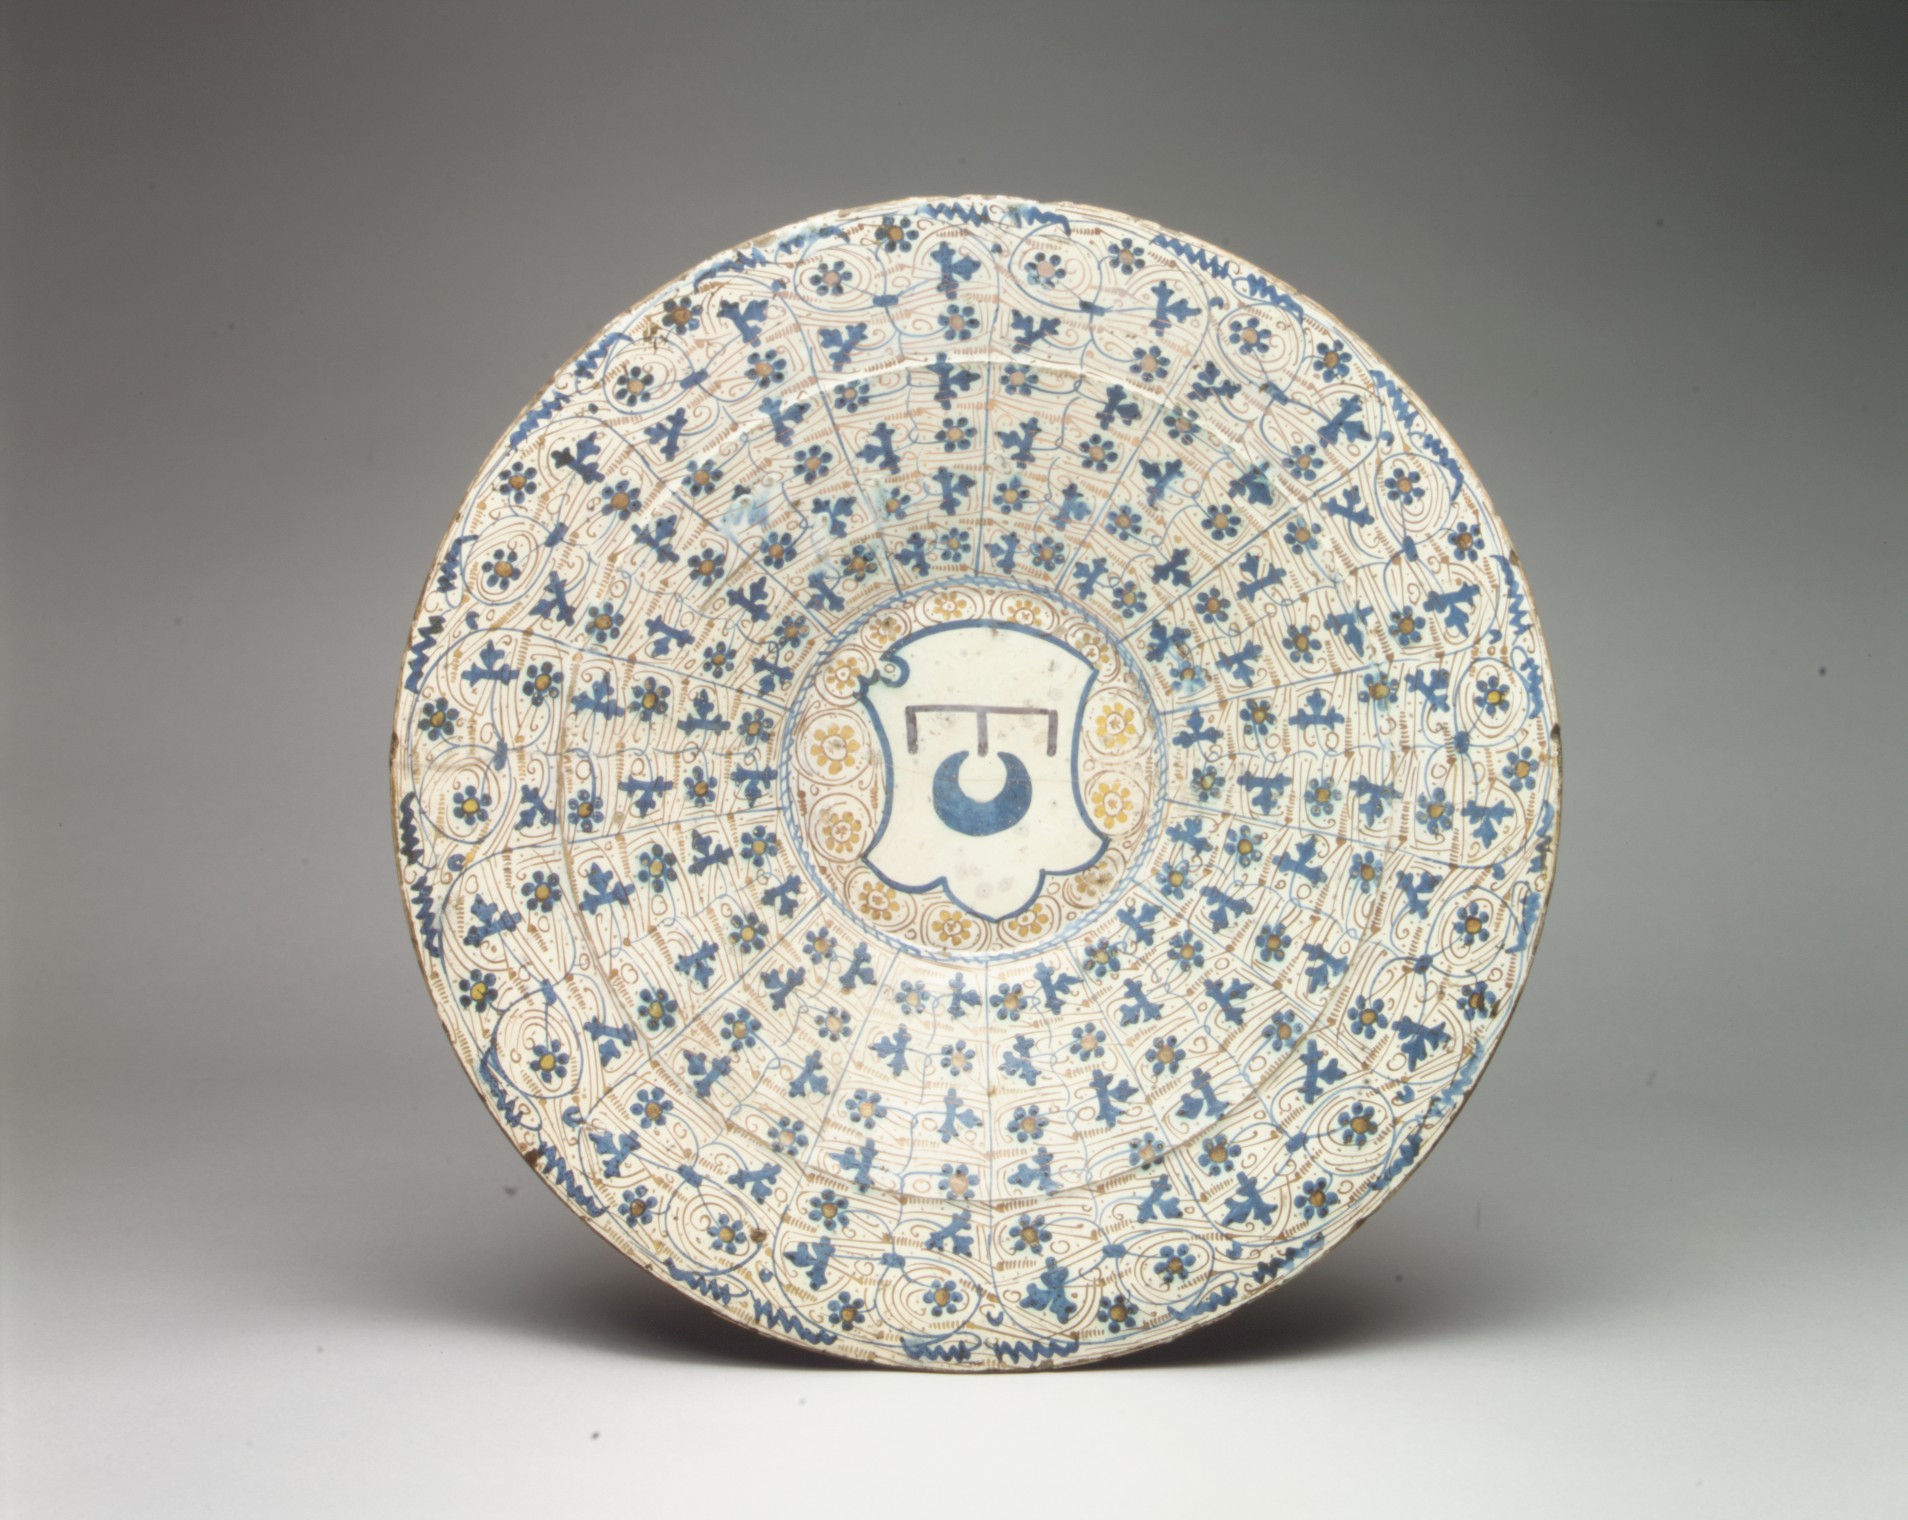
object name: dish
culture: spanish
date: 1430-1460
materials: earthenware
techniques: glazing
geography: spain